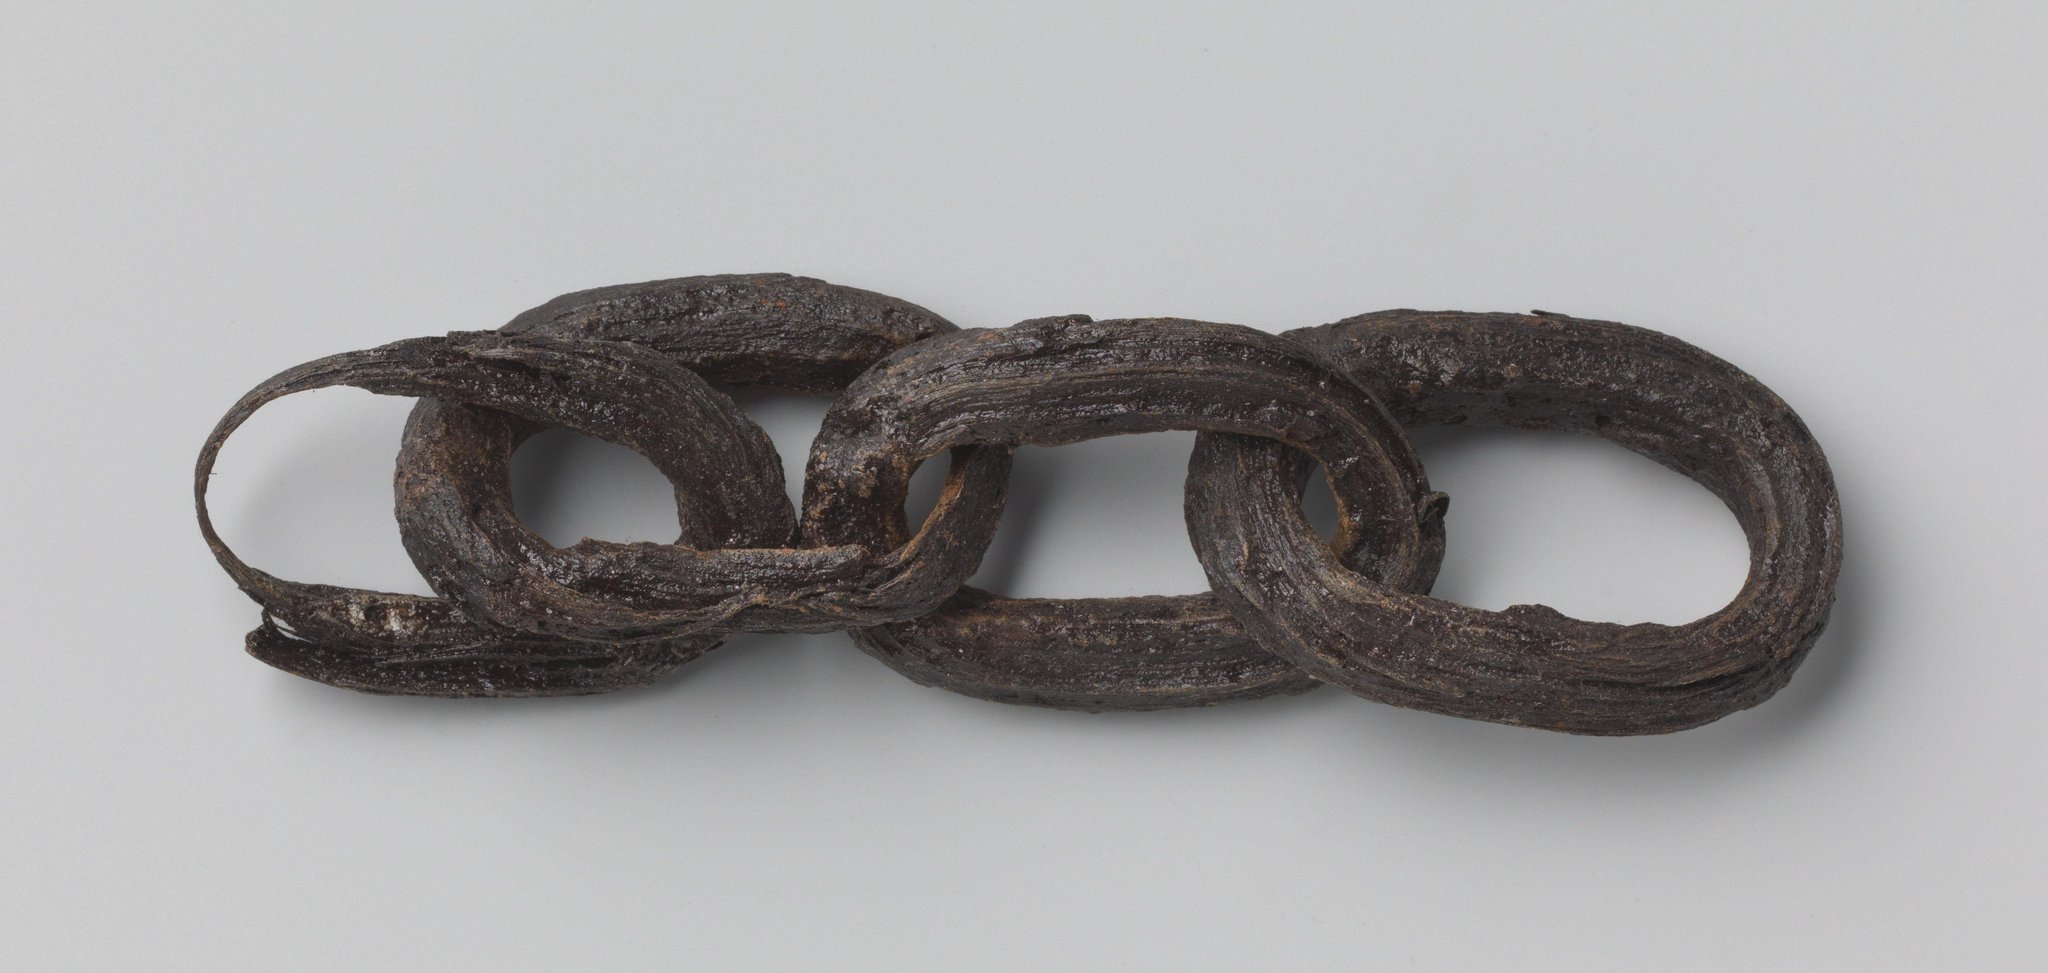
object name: chain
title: Vier aaneengesloten schakels van een ketting uit het wrak van de Oostindiëvaarder Hollandia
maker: Anonymous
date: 1700-1743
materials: iron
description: Vier aaneengesloten schakels van een ketting.